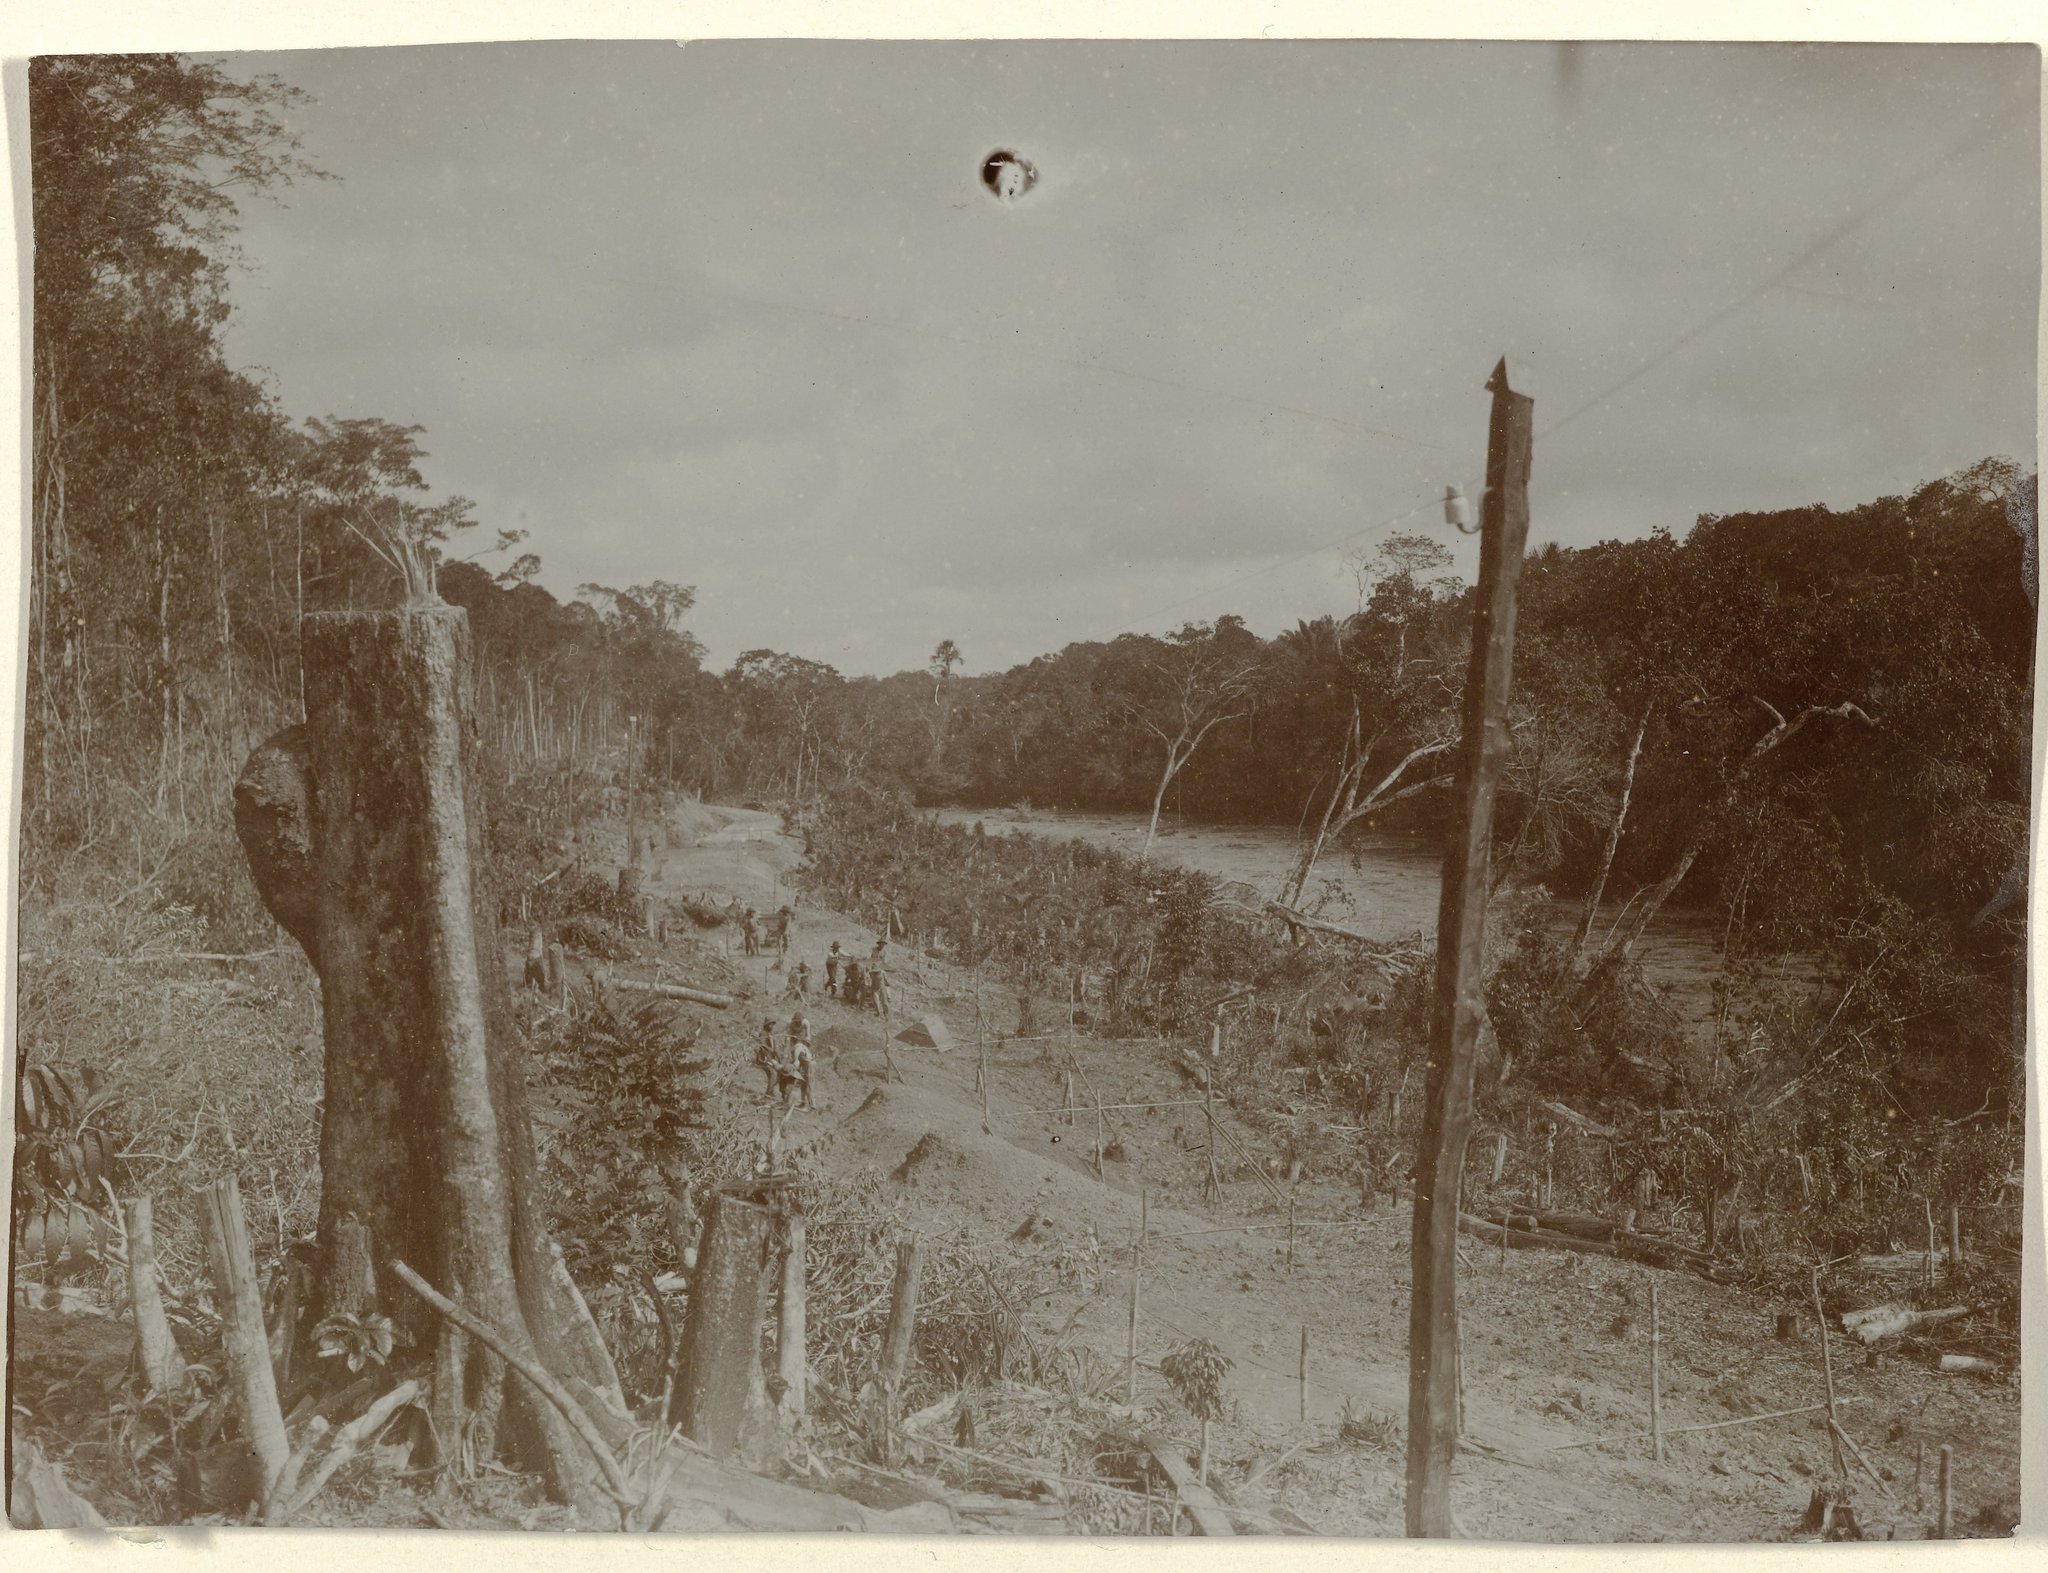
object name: photograph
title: Familie Wesenhagen in Suriname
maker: jacob evert wesenhagen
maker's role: amateurfotograaf, arts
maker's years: 1862-1924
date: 1905-1910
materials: photographic support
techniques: photography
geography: suriname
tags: railway, train, suriname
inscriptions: annotation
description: Grondwerk bij de aanleg spoorweg langs de Sarakreek in Suriname. Aanleg van de Lawaspoorweg in Suriname in de jaren 1903-1912. Onderdeel van een groep objecten afkomstig van de familie Wesenhagen in Suriname.